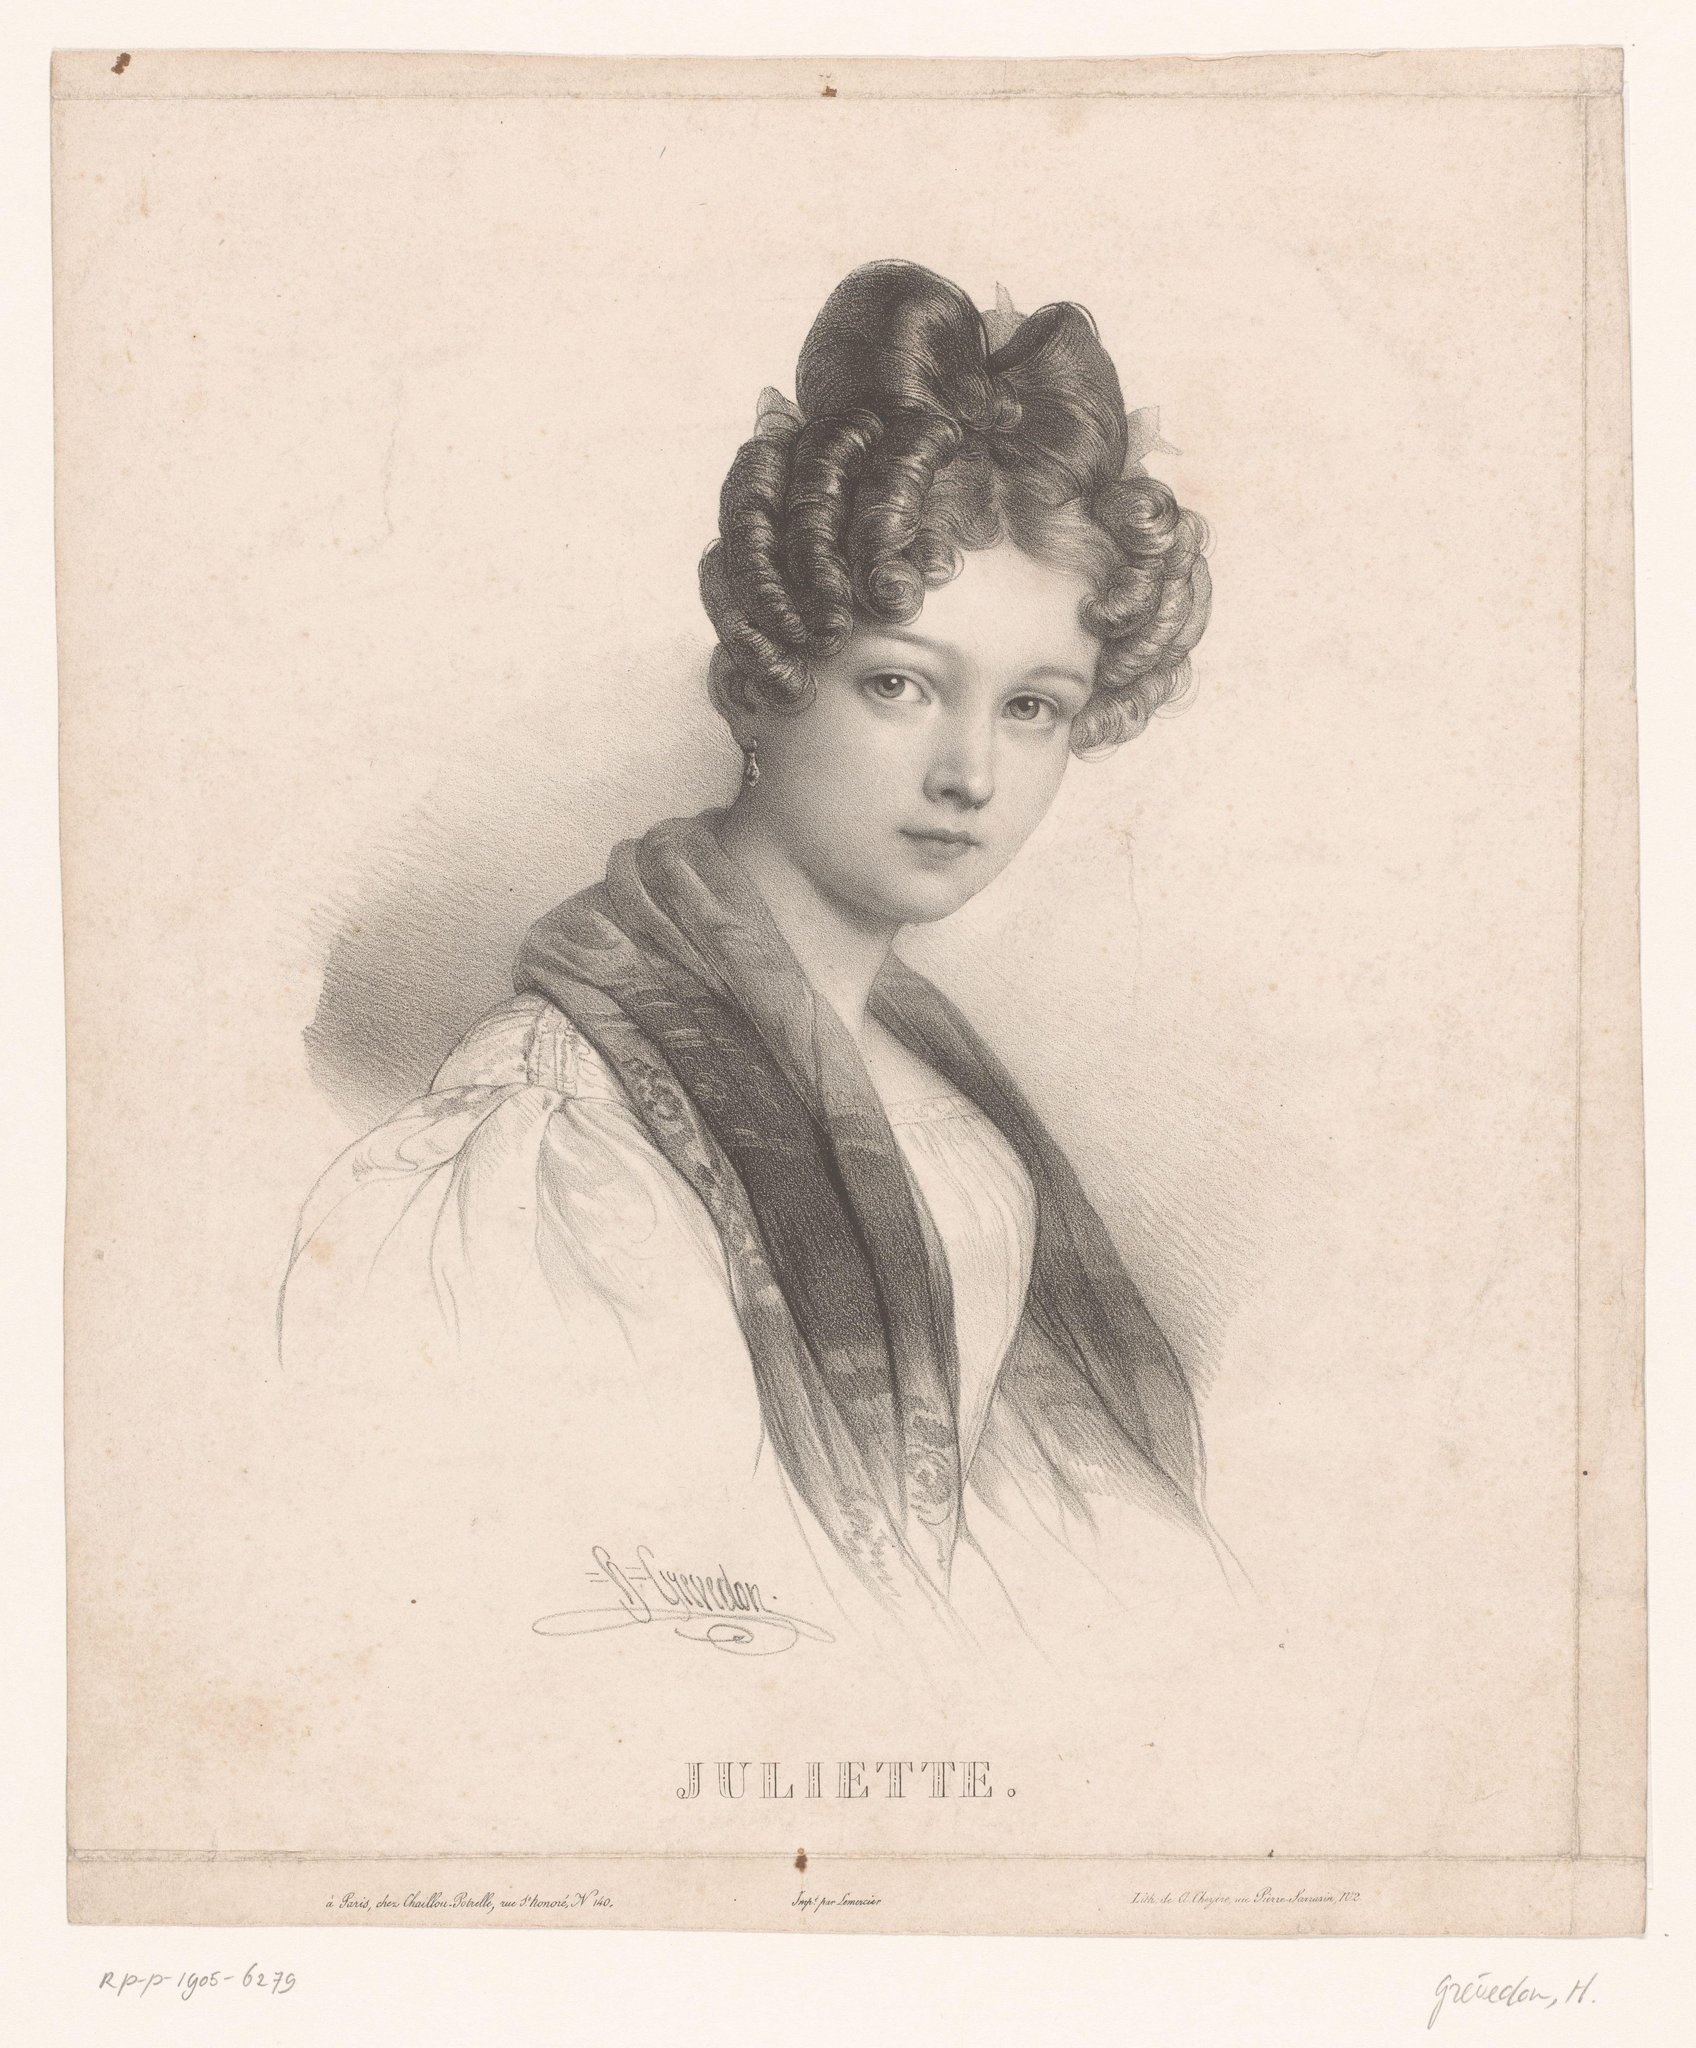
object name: print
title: Alphabet des Dames, ou Recueil de vingt-cinq portraits de fantaisie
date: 1828-1830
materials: paper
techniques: lithograph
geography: paris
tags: adolescent, young woman, maiden, letters, alphabet, script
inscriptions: collector's mark: Lugt 2228a